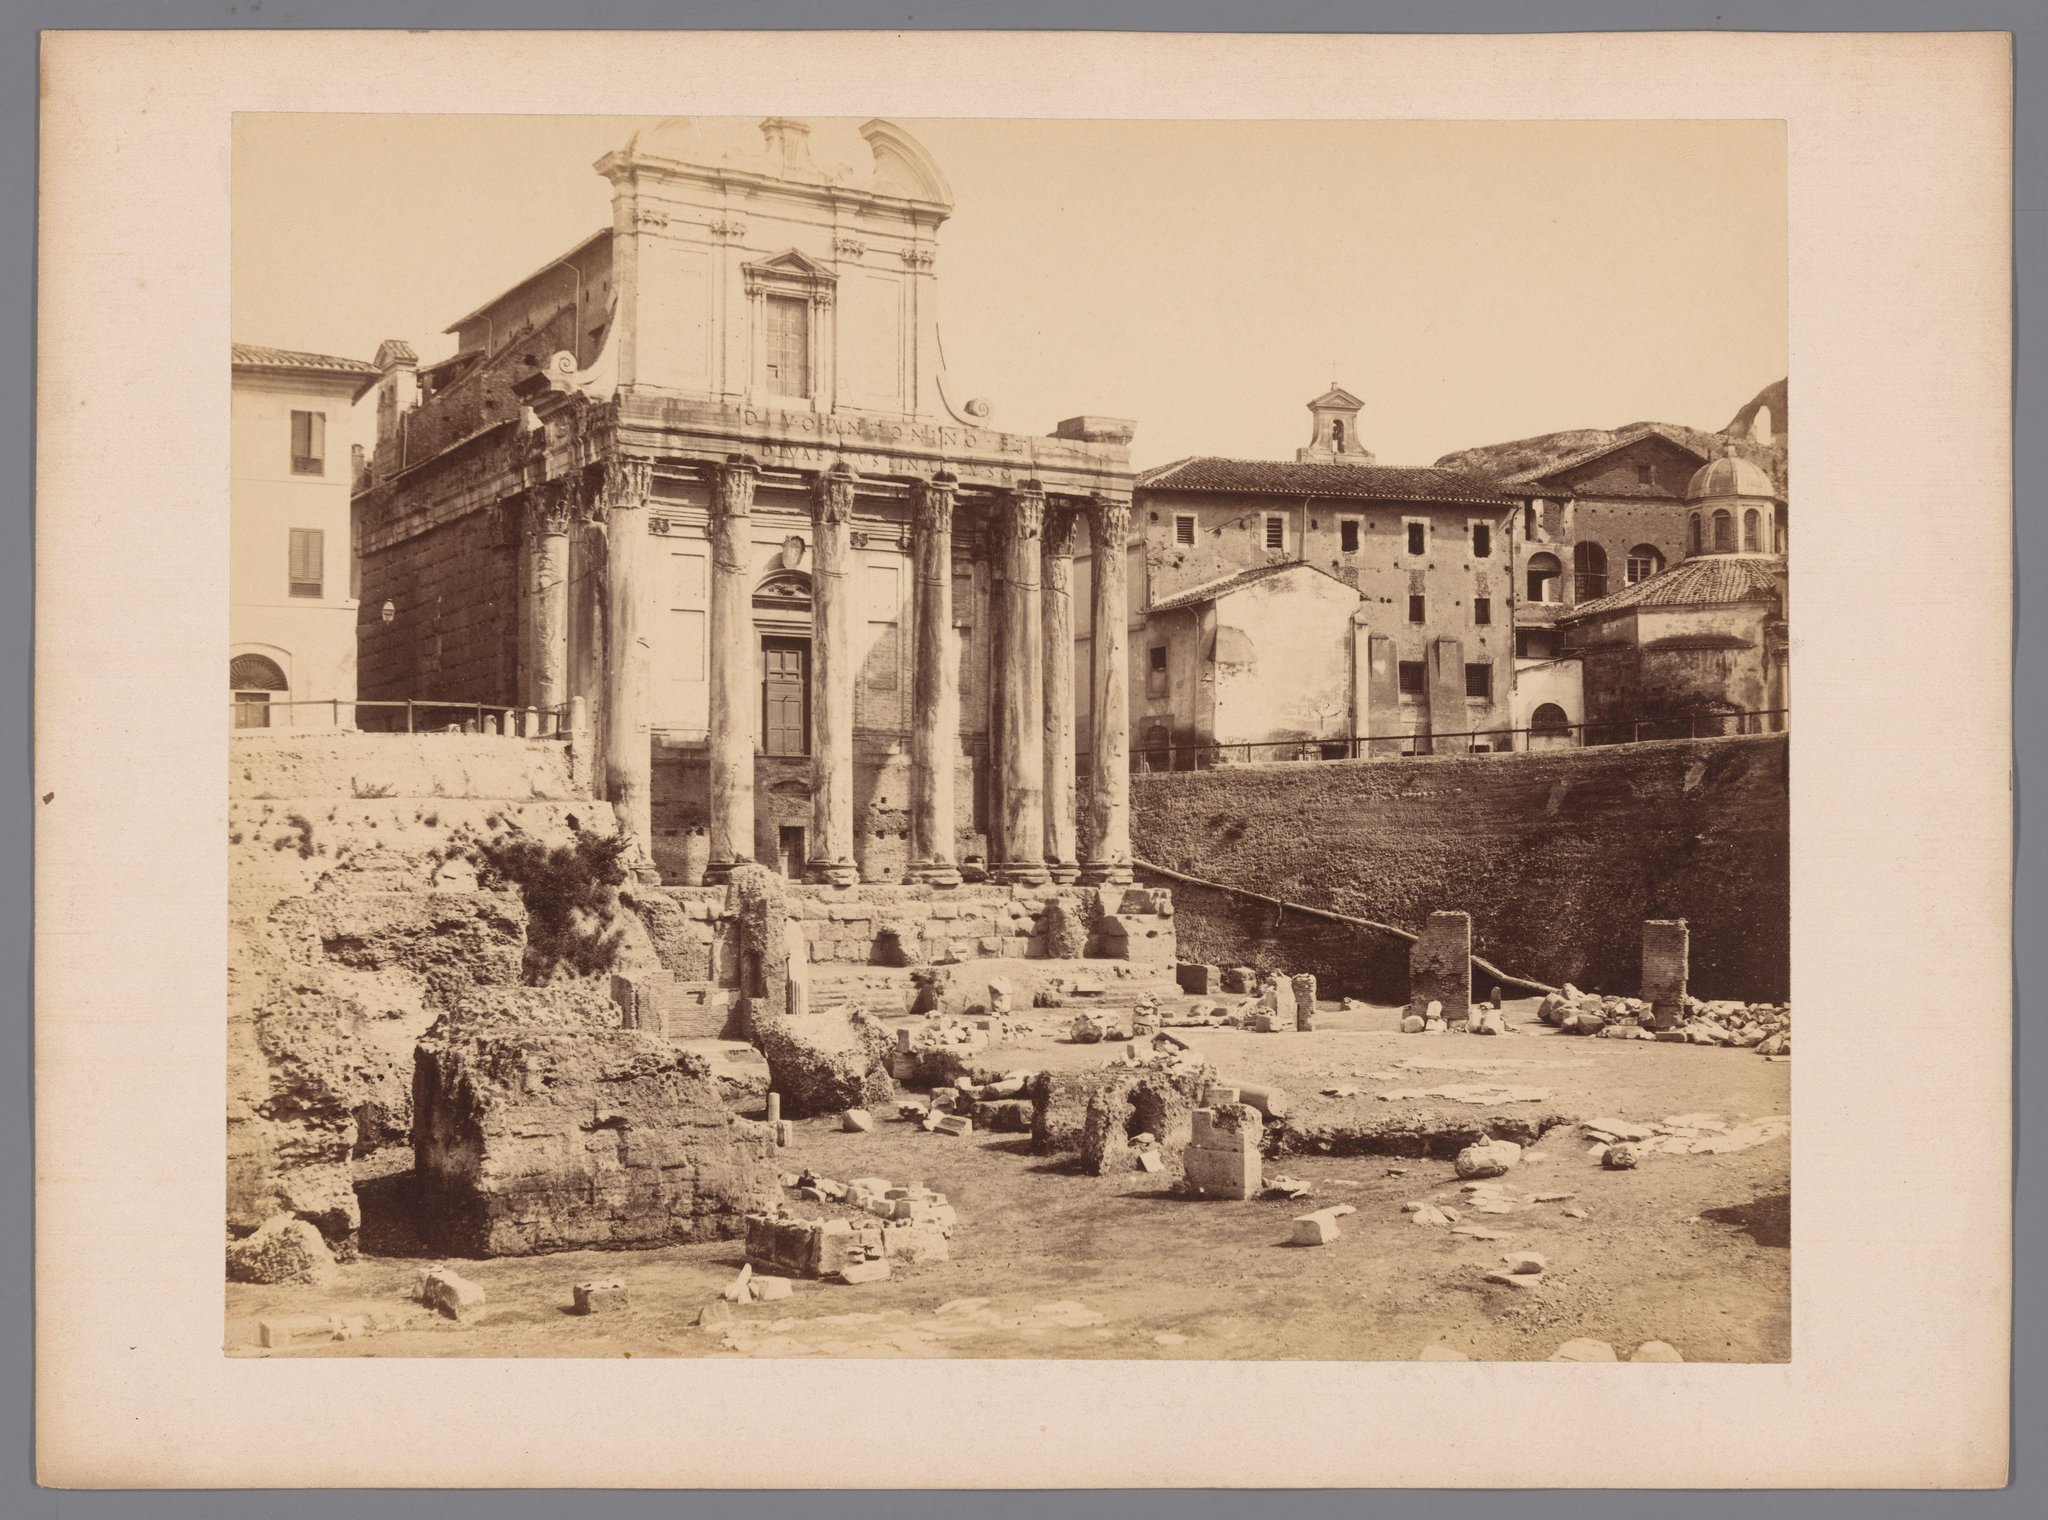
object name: photograph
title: Tempel van Antoninus en Faustina op het Forum Romanum te Rome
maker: Anonymous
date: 1851-1900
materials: cardboard, paper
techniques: albumen print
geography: rome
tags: church (exterior), temple, shrine ~ roman religion